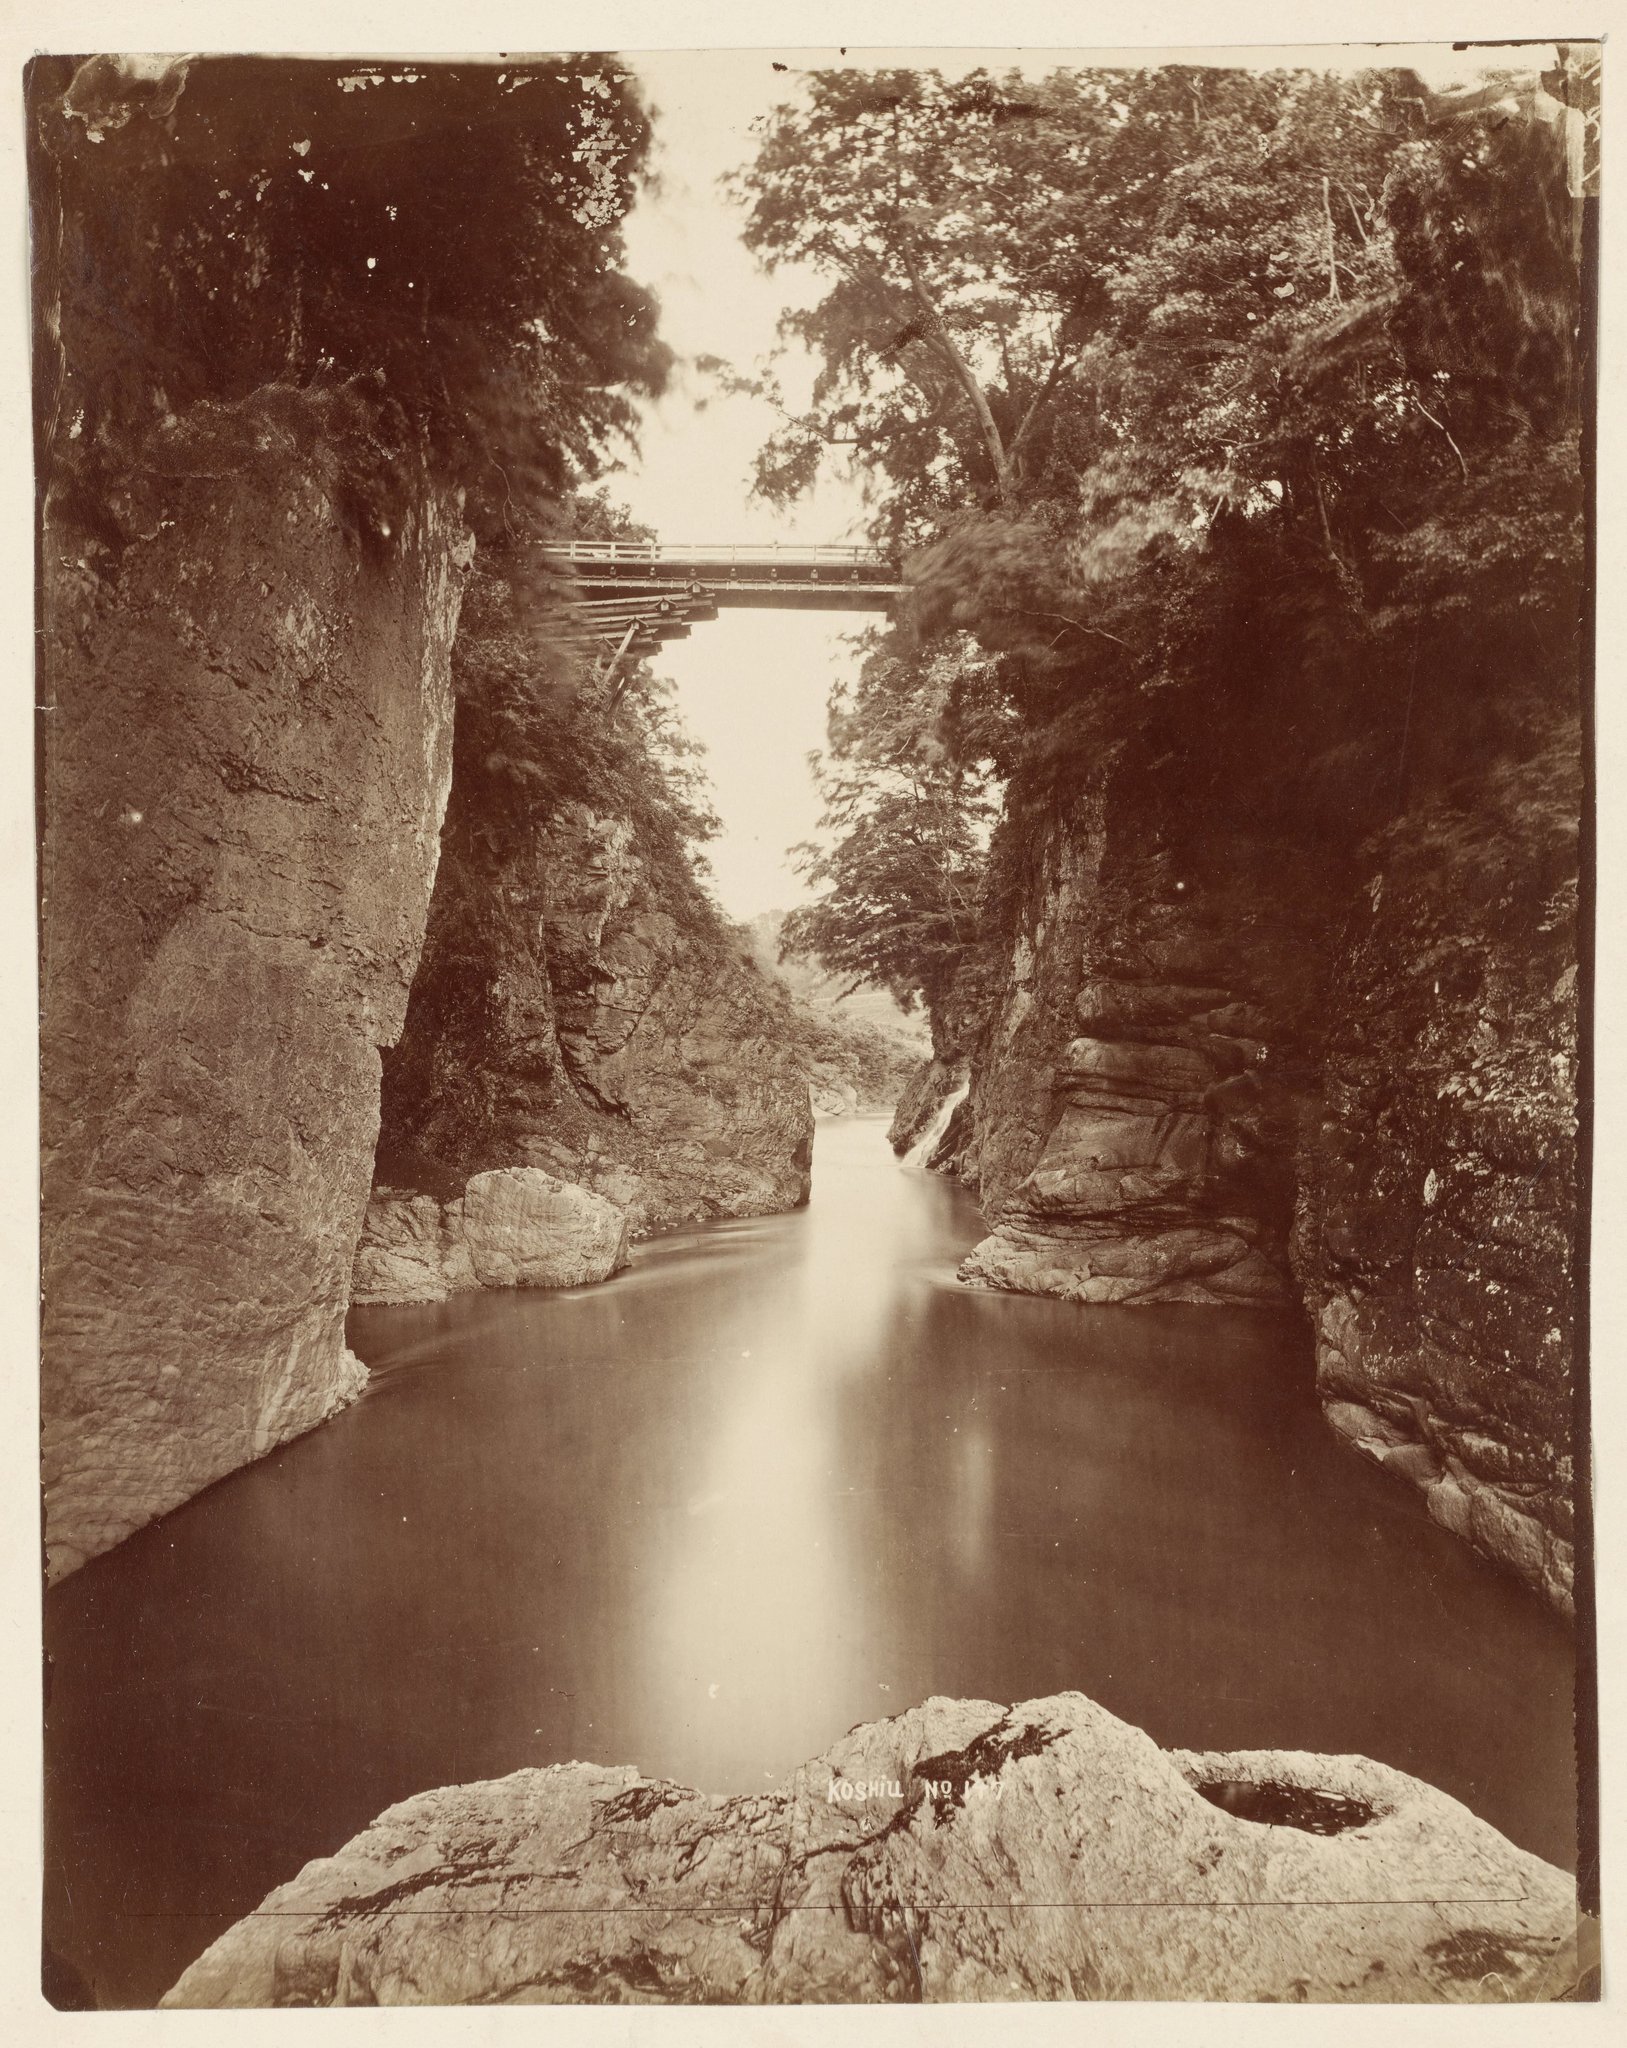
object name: photograph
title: Japan 1884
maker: Anonymous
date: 1884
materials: cardboard, paper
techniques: albumen print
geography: japan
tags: river, japan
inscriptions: number: ‘NO 147’